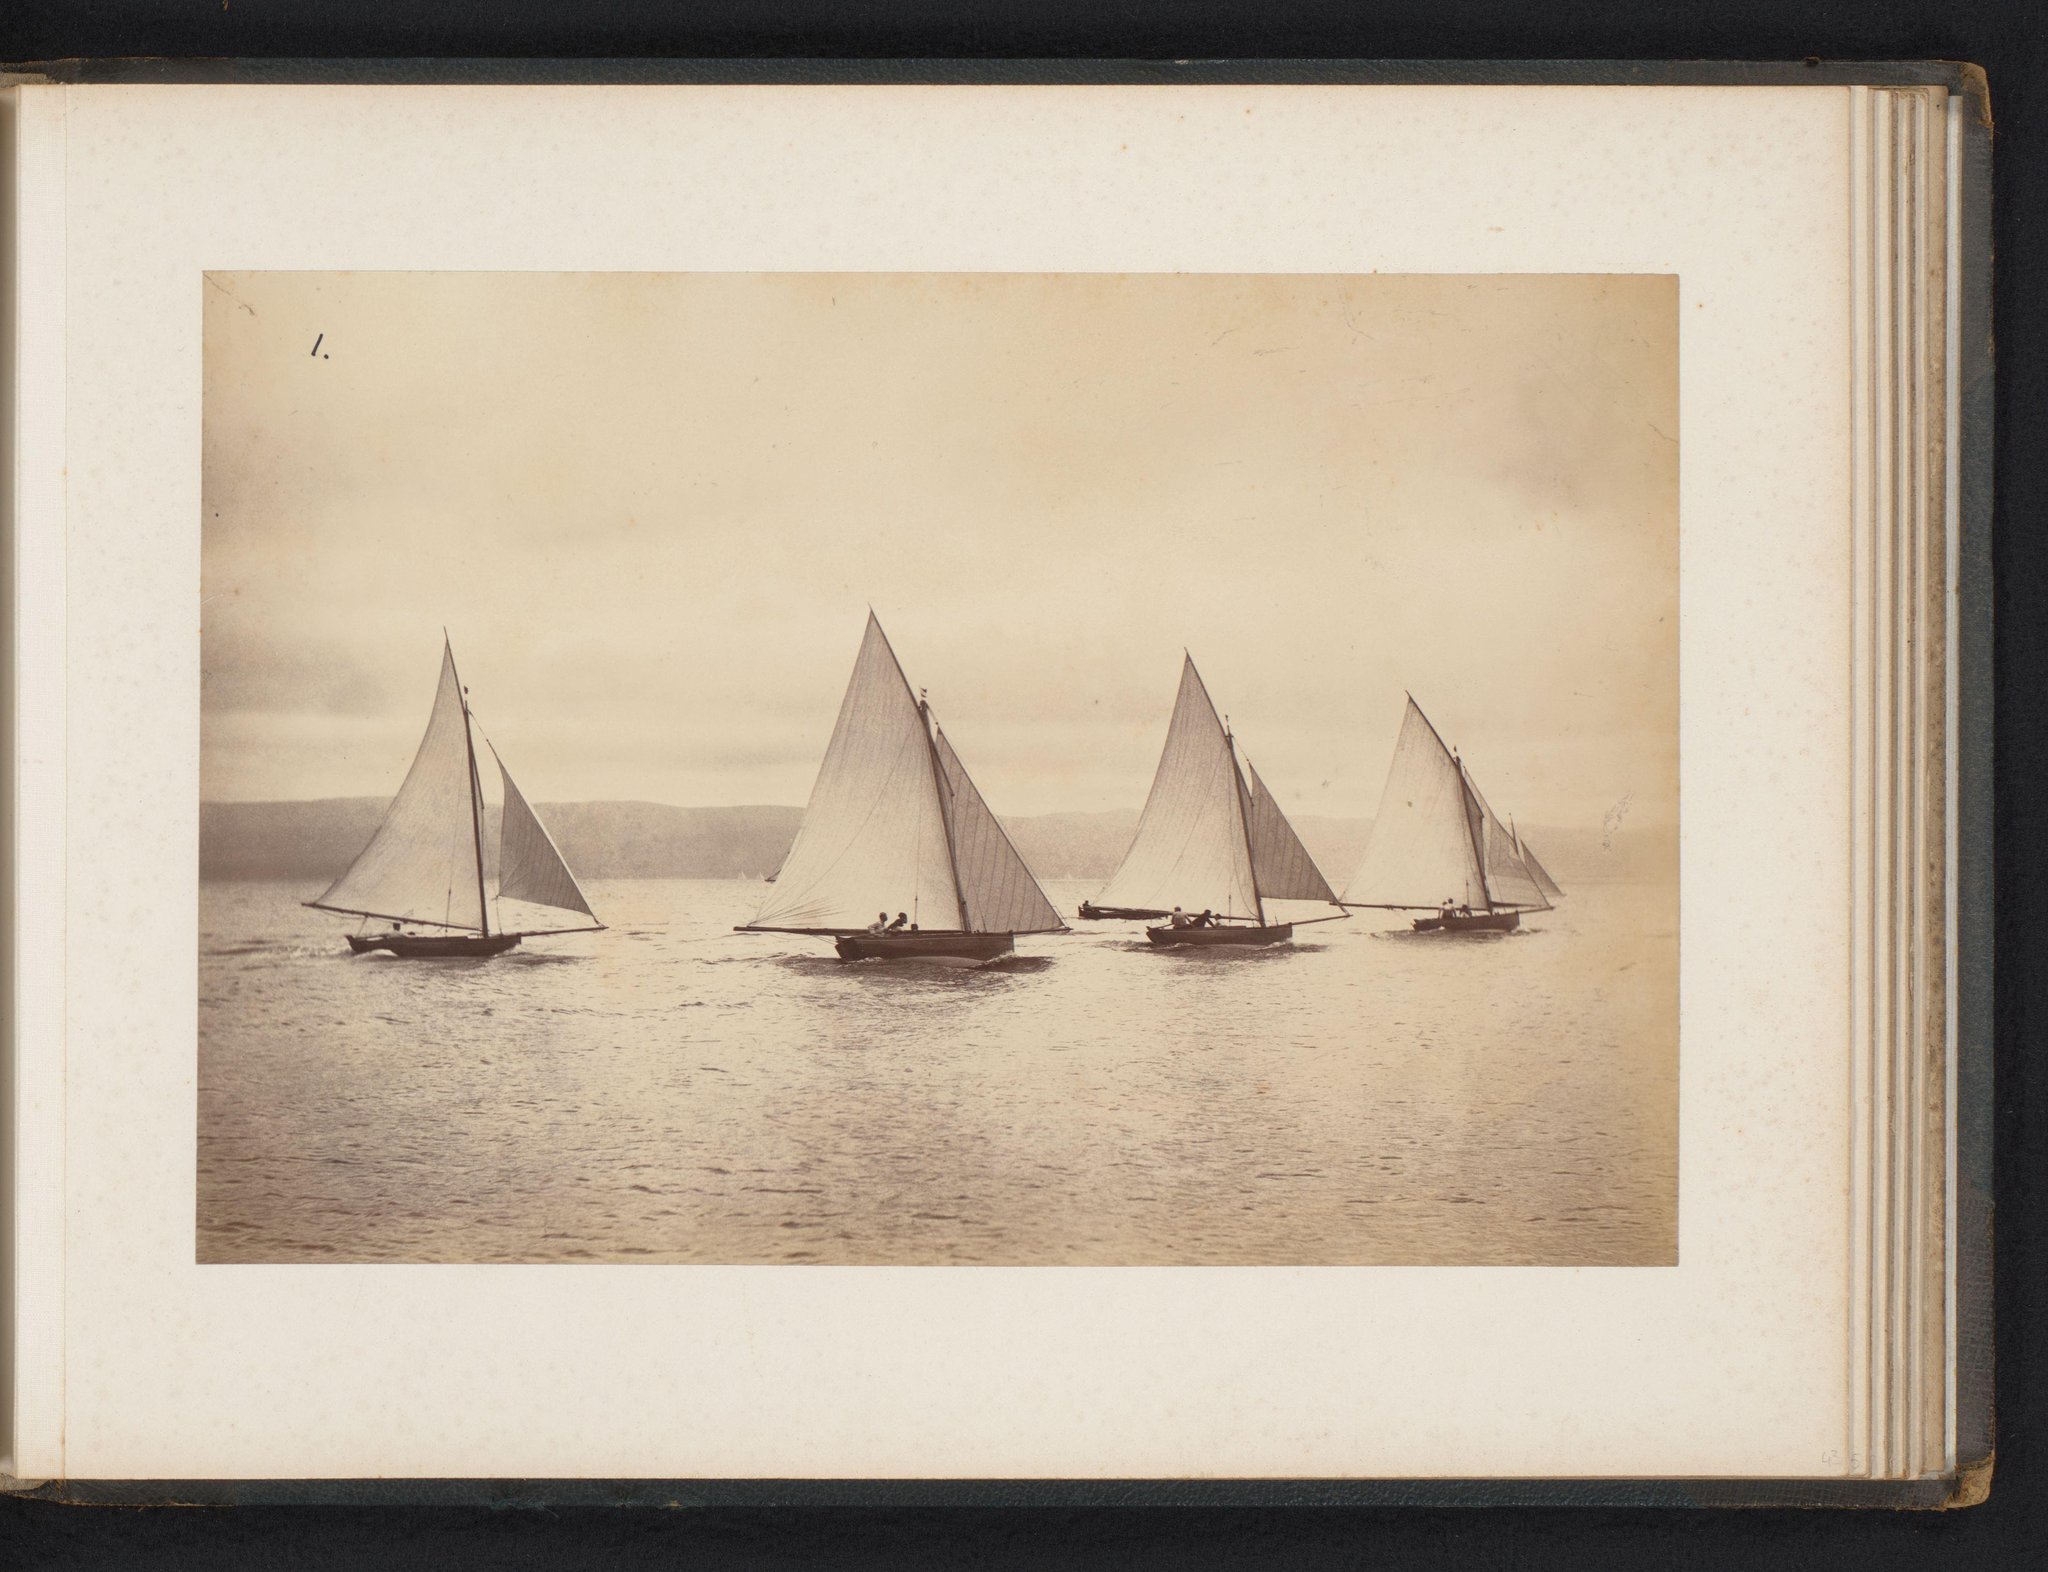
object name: album leaf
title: Zeilschepen, waaronder Dorothy, Caprice en Astore, te water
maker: james adamson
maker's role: fotograaf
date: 1880-1900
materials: photographic support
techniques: albumen print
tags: sailing-ship, sailing-boat, landscapes with waters, waterscapes, seascapes (in the temperate zone)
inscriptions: number: ‘1’, check stamp: ‘Adamson, Rothesay.H.B/ Copyright’